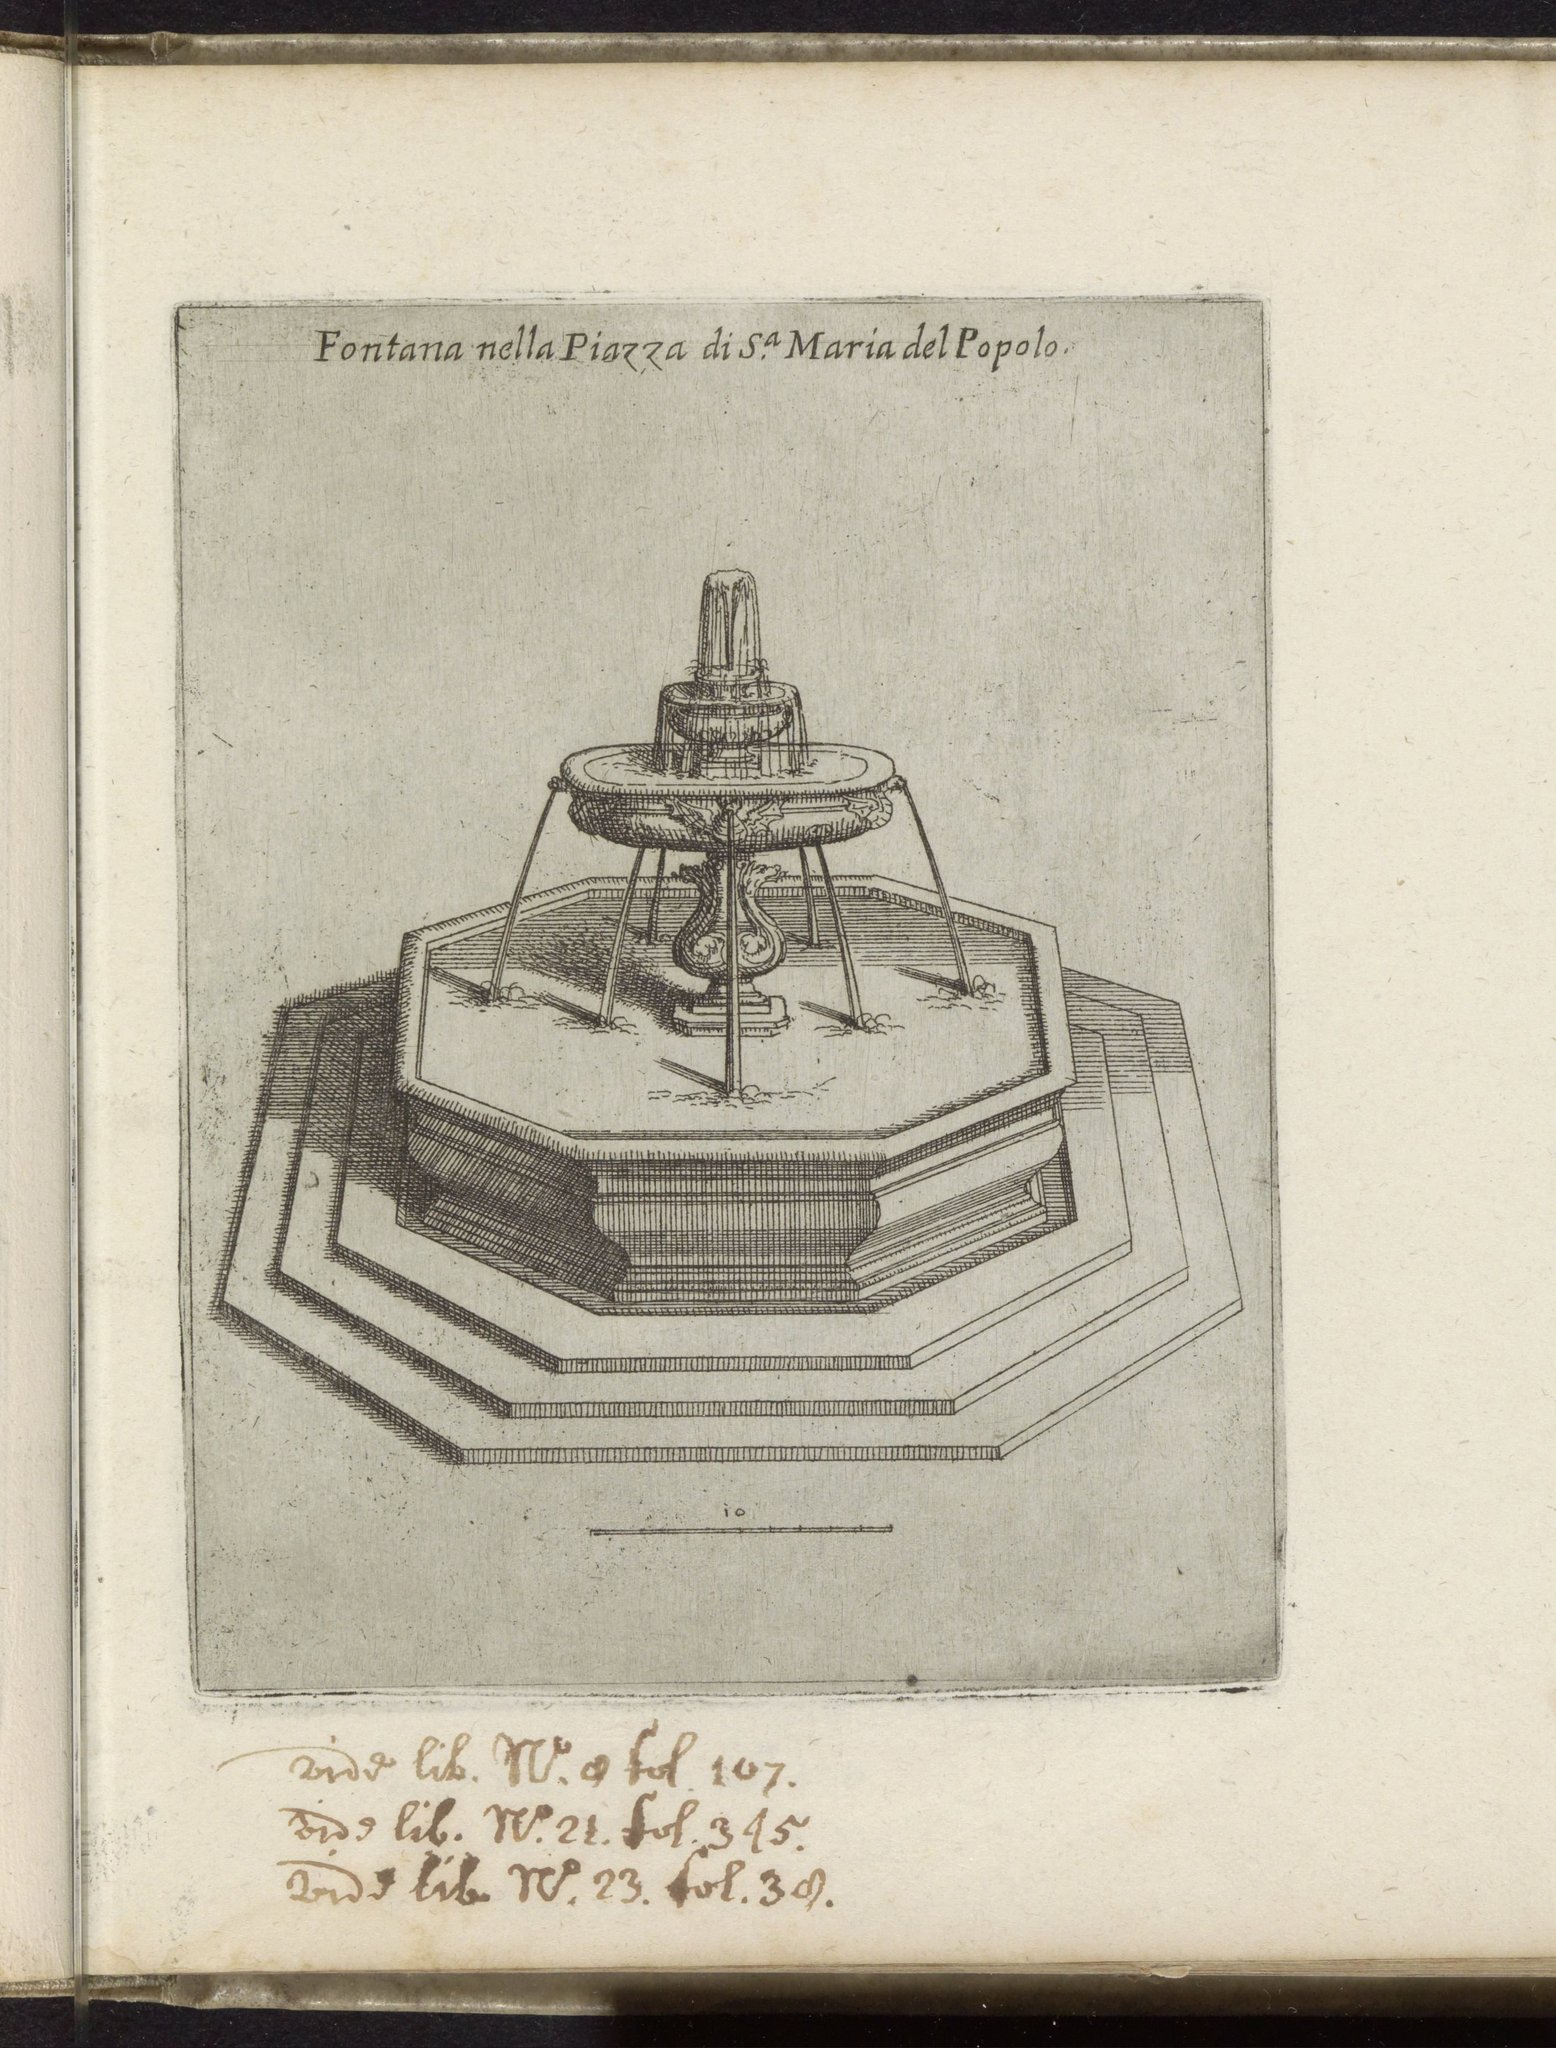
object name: print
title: Raccolta delle principali fontane dell'inclitta città di Roma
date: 1637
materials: paper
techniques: etching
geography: italy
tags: ornamental fountain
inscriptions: inscription: ‘Ende lib. No. 8 fol. 107./ Ende lib. No. 21. fol. 345./ Ende lib. No. 23. fol. 38.’, number: ‘46’, inscription: ‘Ende lib. No. 8 fol. 92./ Ende lib. No. 21. fol. 206./ Ende lib. No. 23. fol. 257.’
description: Deze prent maakt deel uit van een reeks van ten minste 20 prenten (+ titelprent) van fonteinen in Rome.